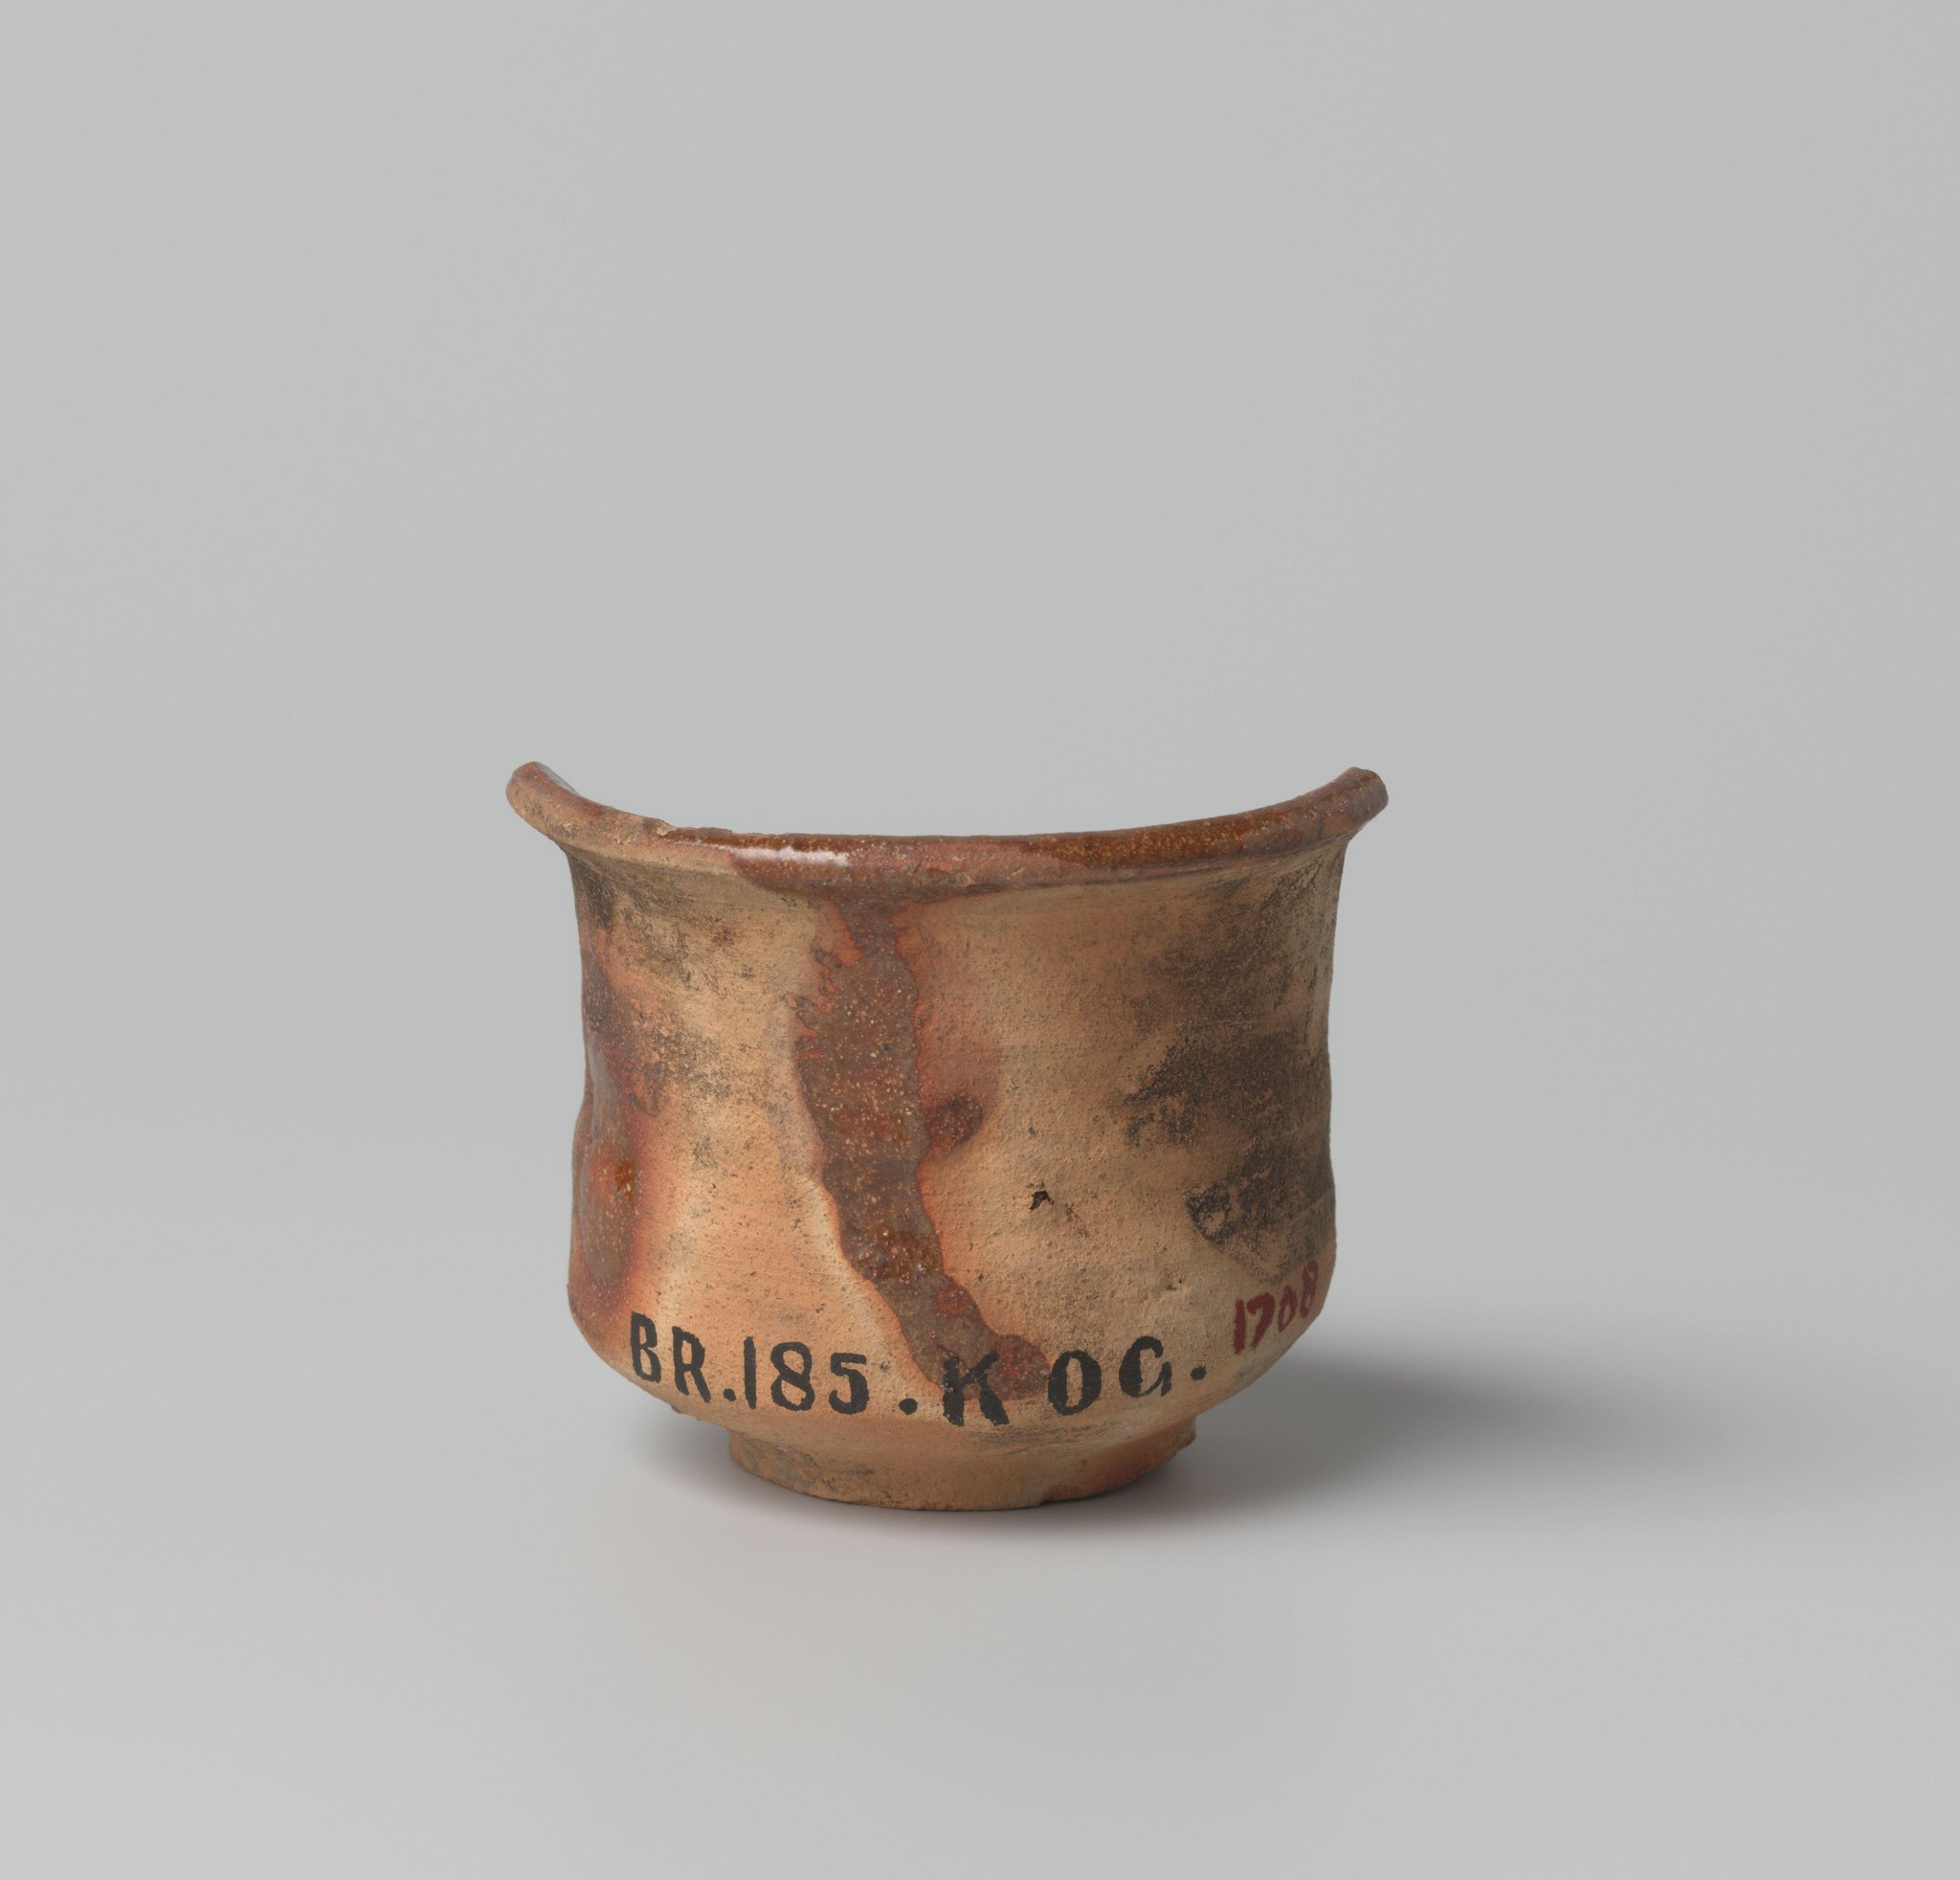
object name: ointment vessel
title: Zalfpot van roodbakkend aardewerk, aan de binnenzijde voorzien van loodglazuur, beschadigd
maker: Anonymous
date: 1500-1799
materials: earthenware, glaze